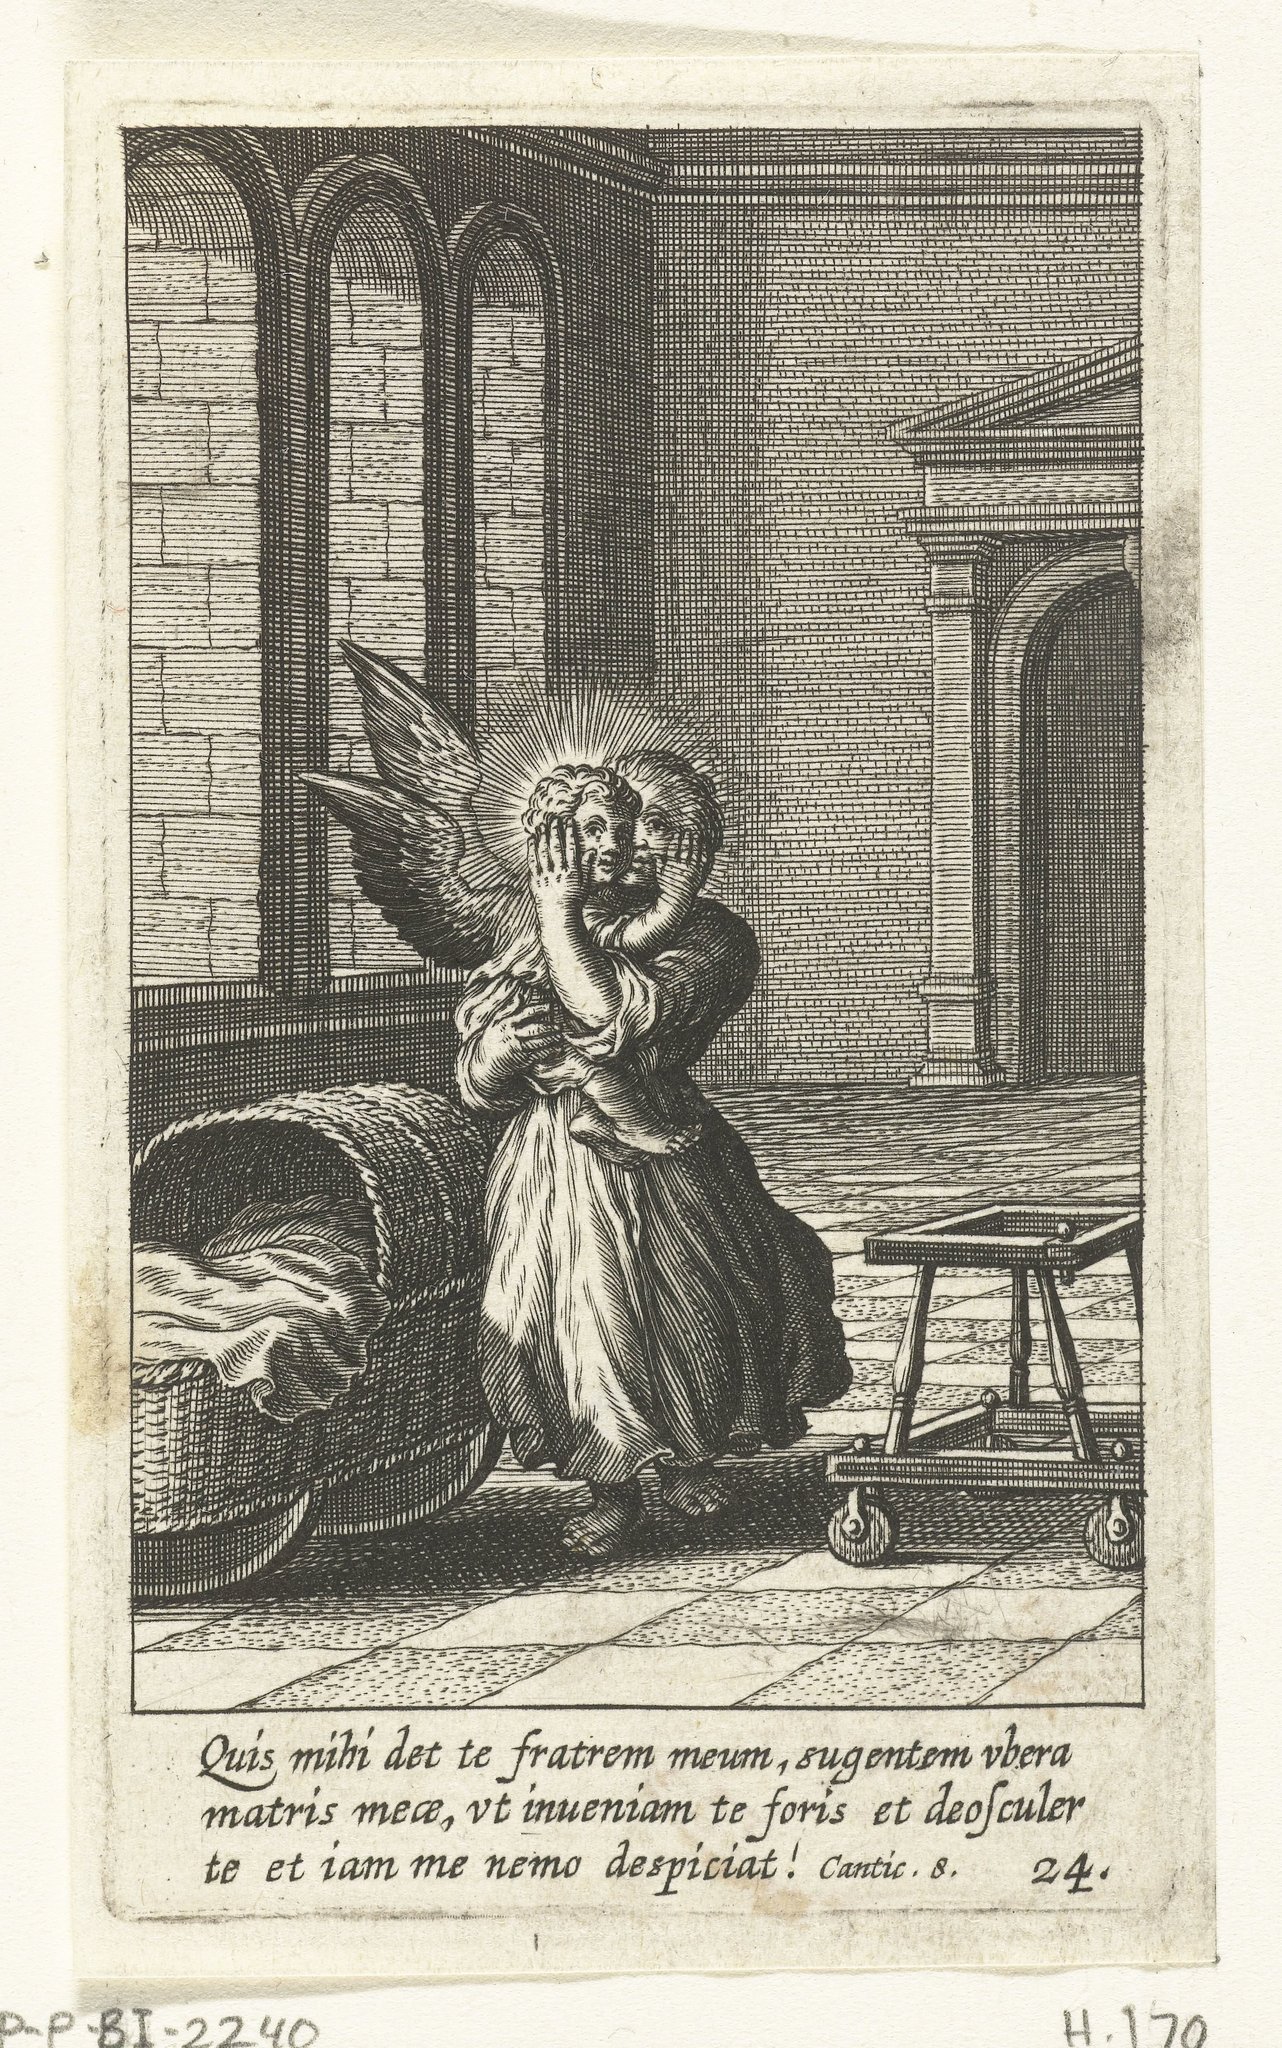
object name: print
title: Pia desideria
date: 1590-1624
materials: paper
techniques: engraving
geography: antwerp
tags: cradle, crib, implements for learning to walk, go-cart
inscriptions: inscription: ‘Quis mihi det te fratrem meum sugentem vbera matris meæ, vt inveniam te foris, & deosculer te, et iam nemo me despiciat!’, collector's mark: Lugt 240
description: Boekillustratie uit: Herman Hugo, Pia desideria emblematis, elegiis & affectibus S. S. Patrum illustrata, Antwerpen 1624, afb. 24